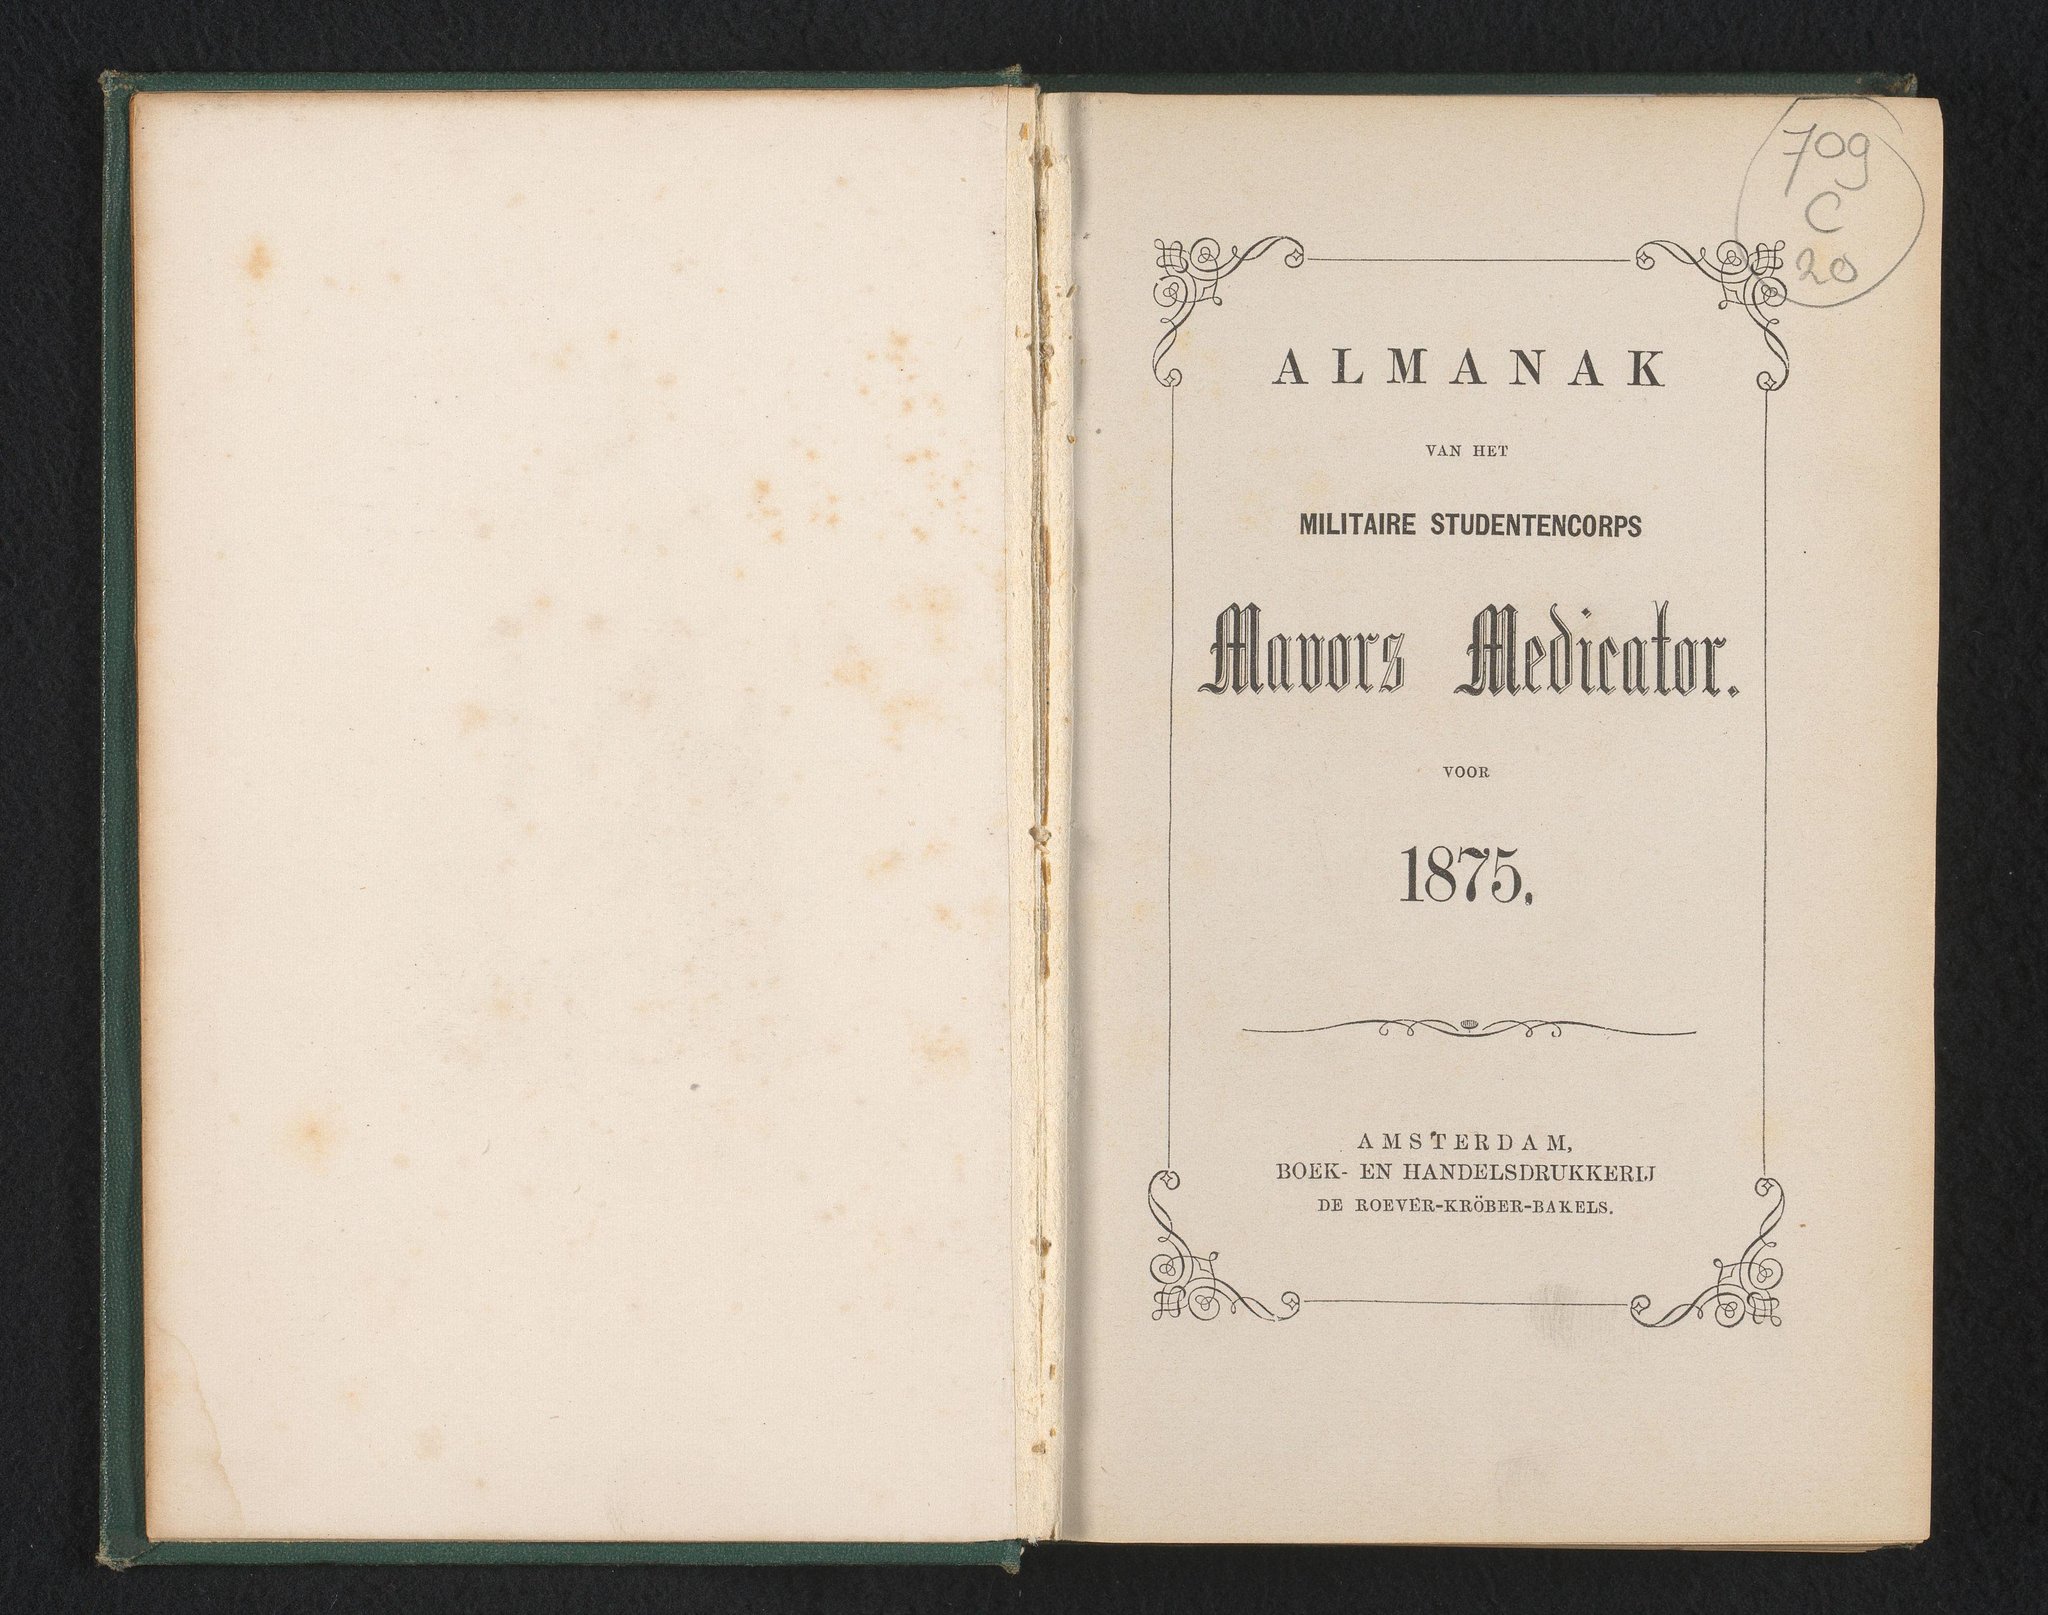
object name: book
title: Almanak van het Militaire Studentencorps Mavors Medicator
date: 1875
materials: cardboard, paper, textile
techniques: albumen print, printing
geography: amsterdam